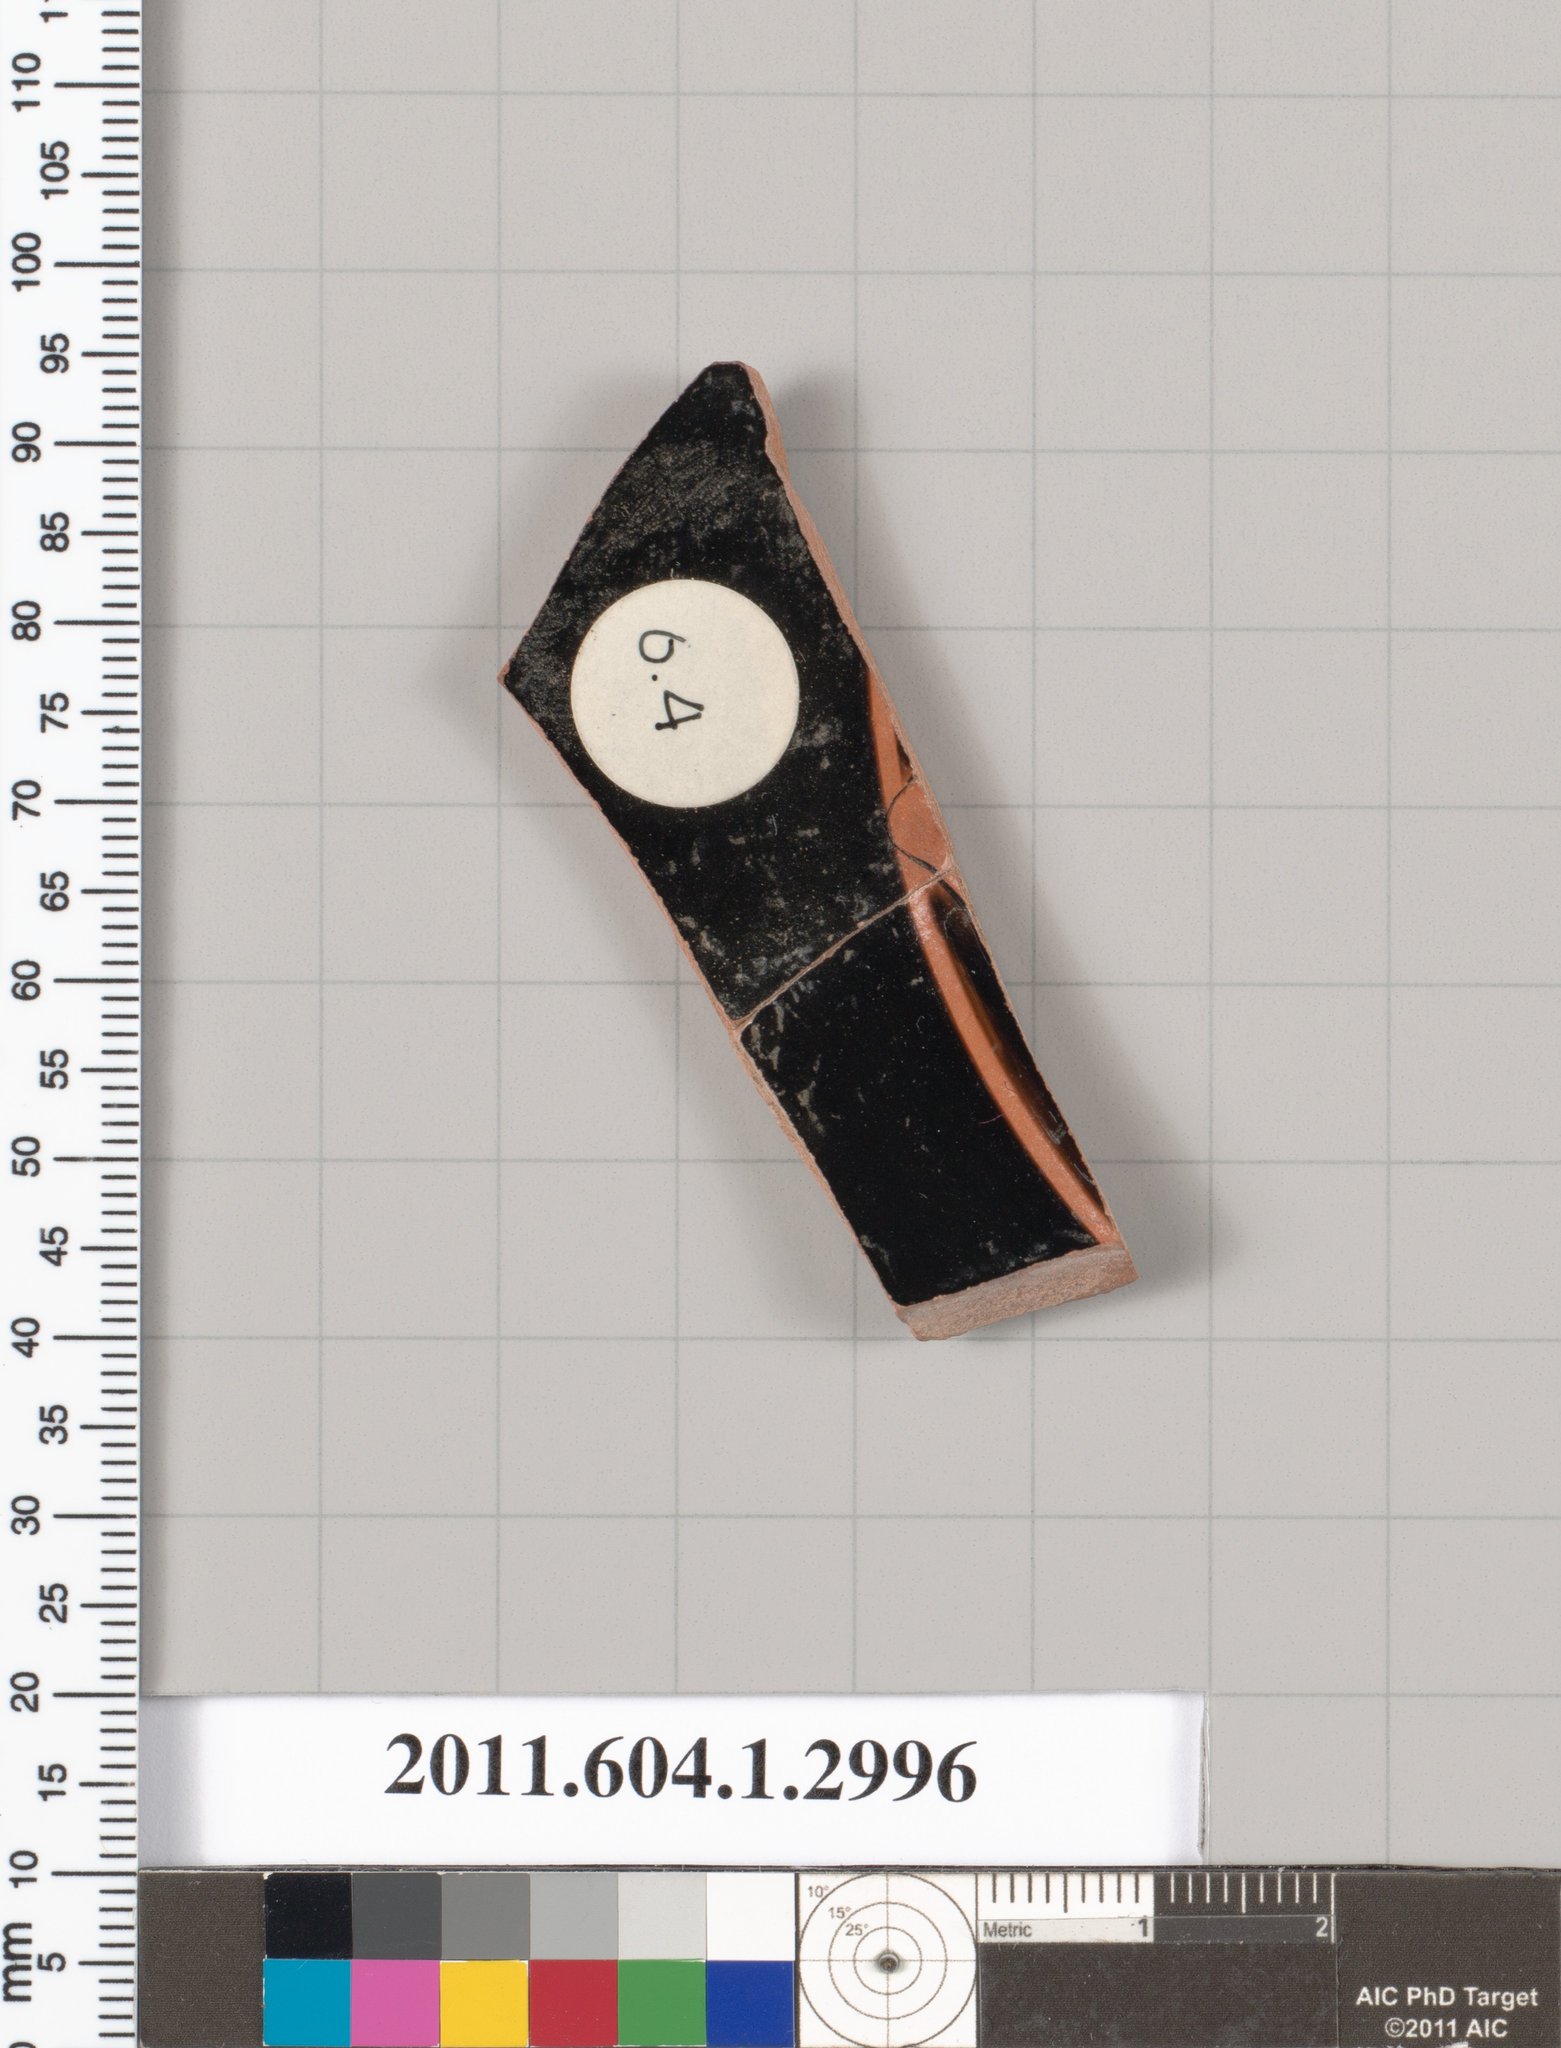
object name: kylix fragment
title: Terracotta fragment of a kylix (drinking cup)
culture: greek, attic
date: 500-490 BCE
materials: terracotta